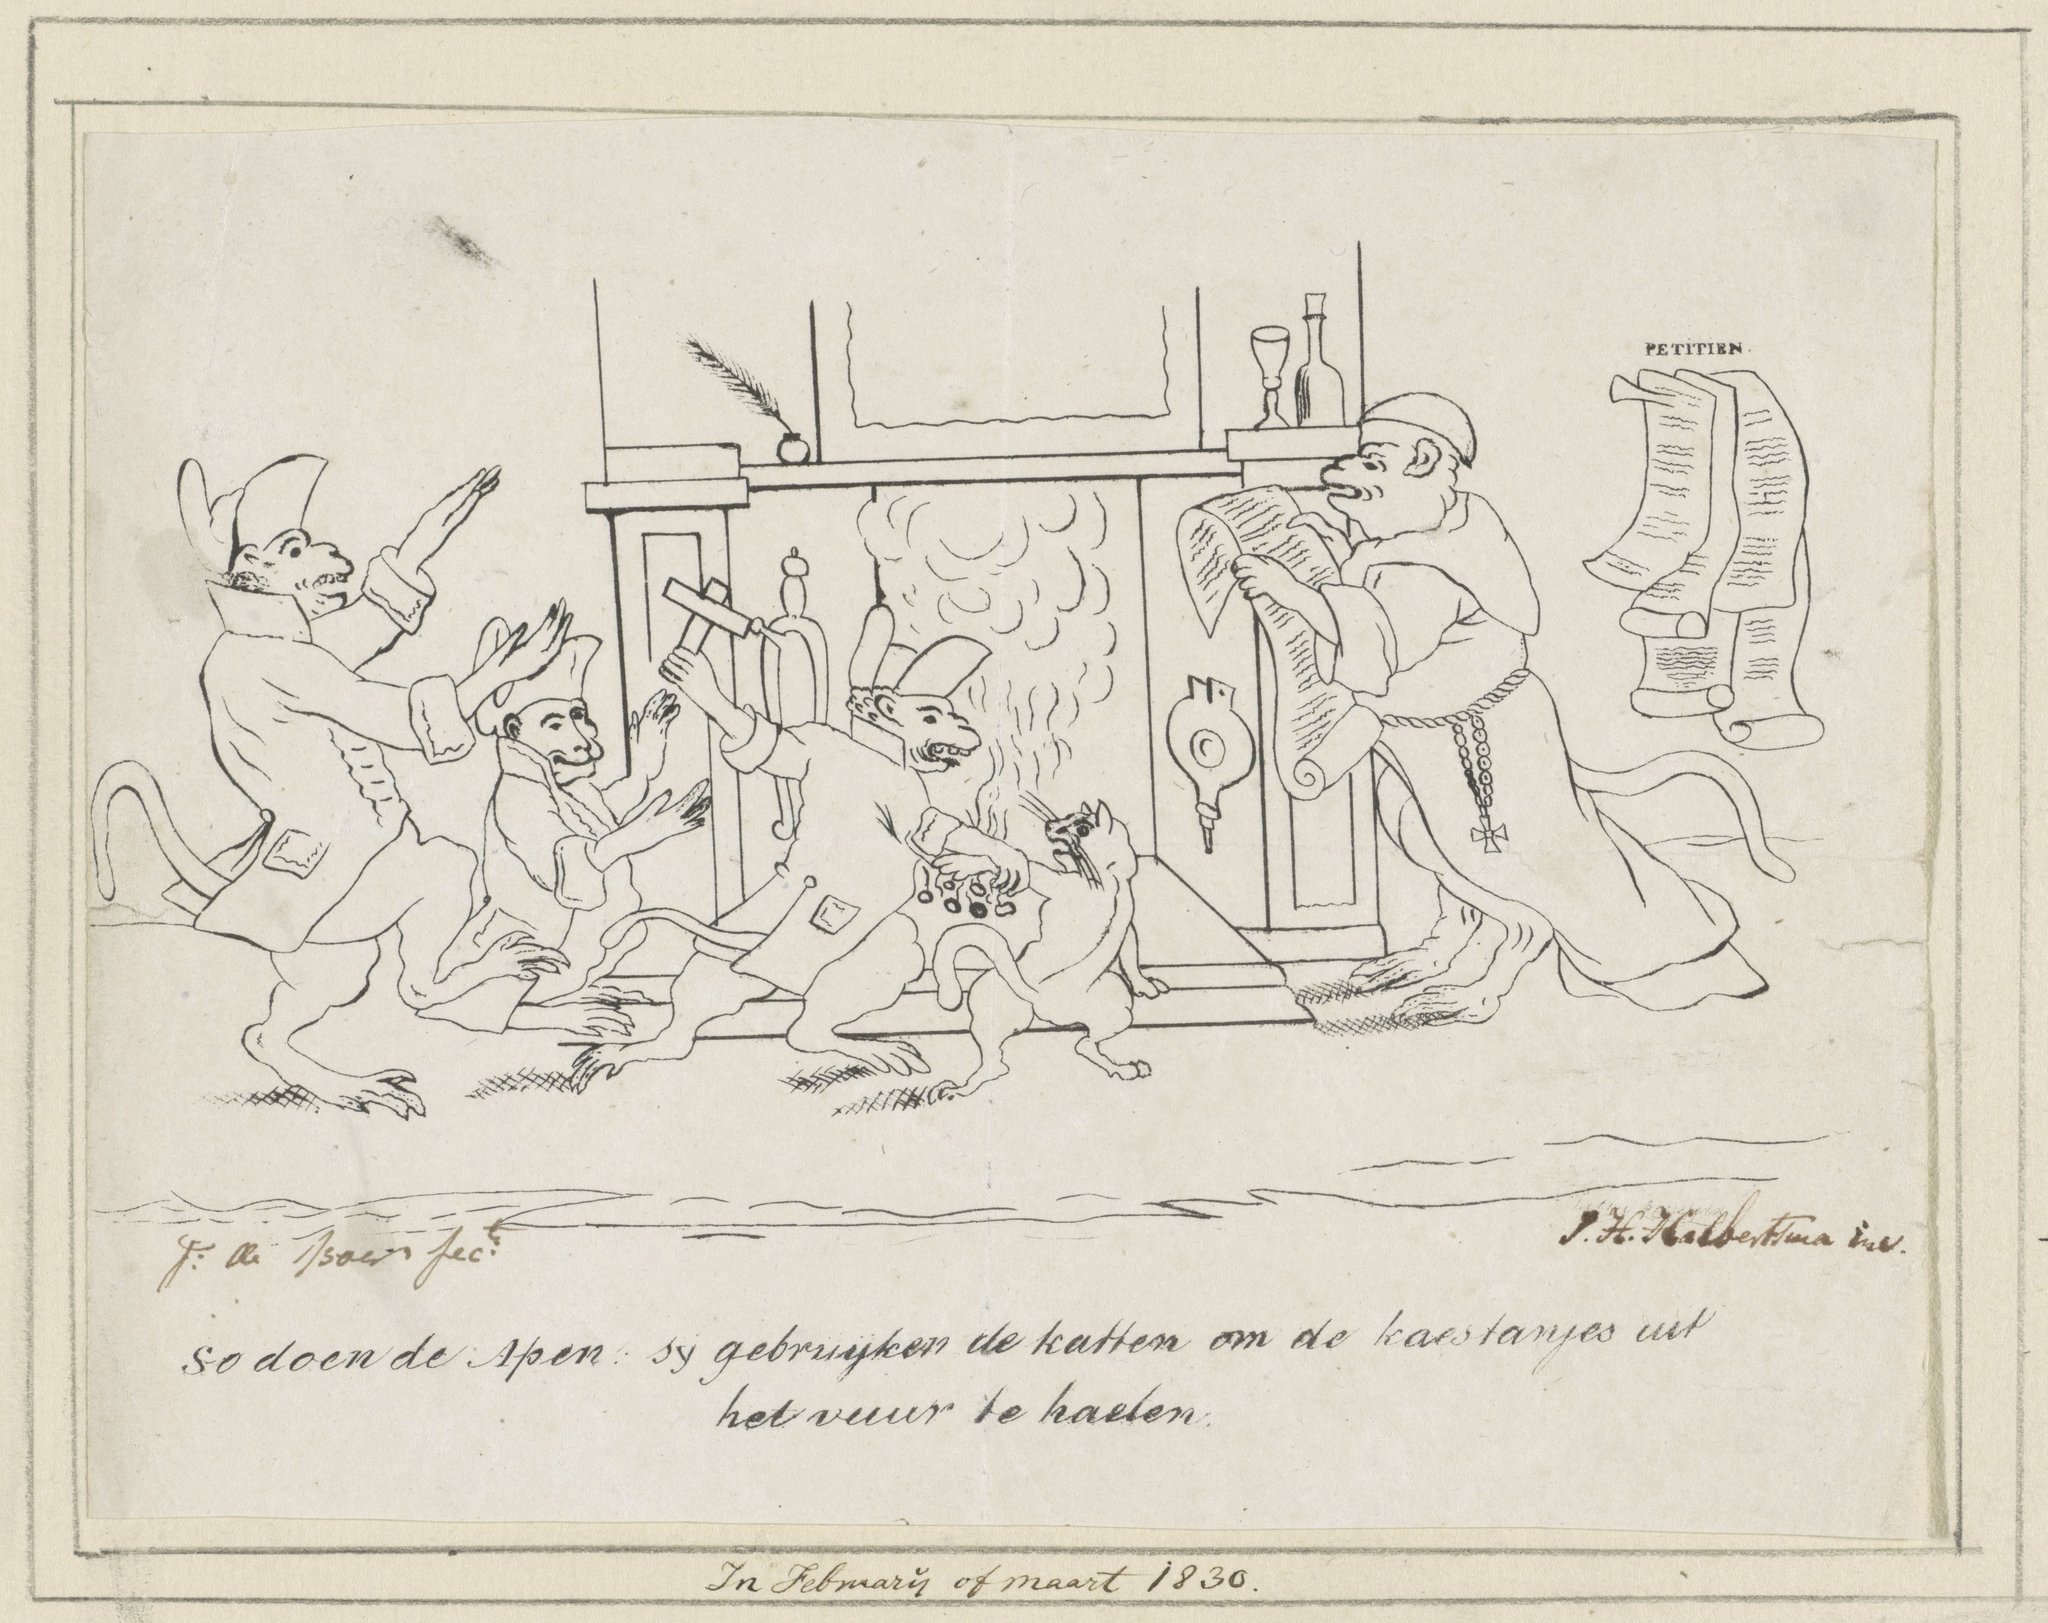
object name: print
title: Spotprent op Louis de Potter, 1828-1830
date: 1828-1830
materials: paper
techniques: lithograph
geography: amsterdam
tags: bruges, politician, cat, monkeys, apes, animals acting as human beings, roasting, grilling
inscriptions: inscription: ‘J: de Boer fec.t / J.H. Halbertsma inv. / † 1869 / In February of maart 1830’, collector's mark: Lugt 2228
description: Spotprent op Louis de Potter die zich voor de Belgische geestelijkheid inspande maar voor hun karretje gespannen werd, ca. 1828-1830. Vier apen gekleed als geestelijken dwingen een kat om de kastanjes uit een haardvuur te halen. Aan de muur hangt een stel petitiën. Met tweeregelig onderschrift.